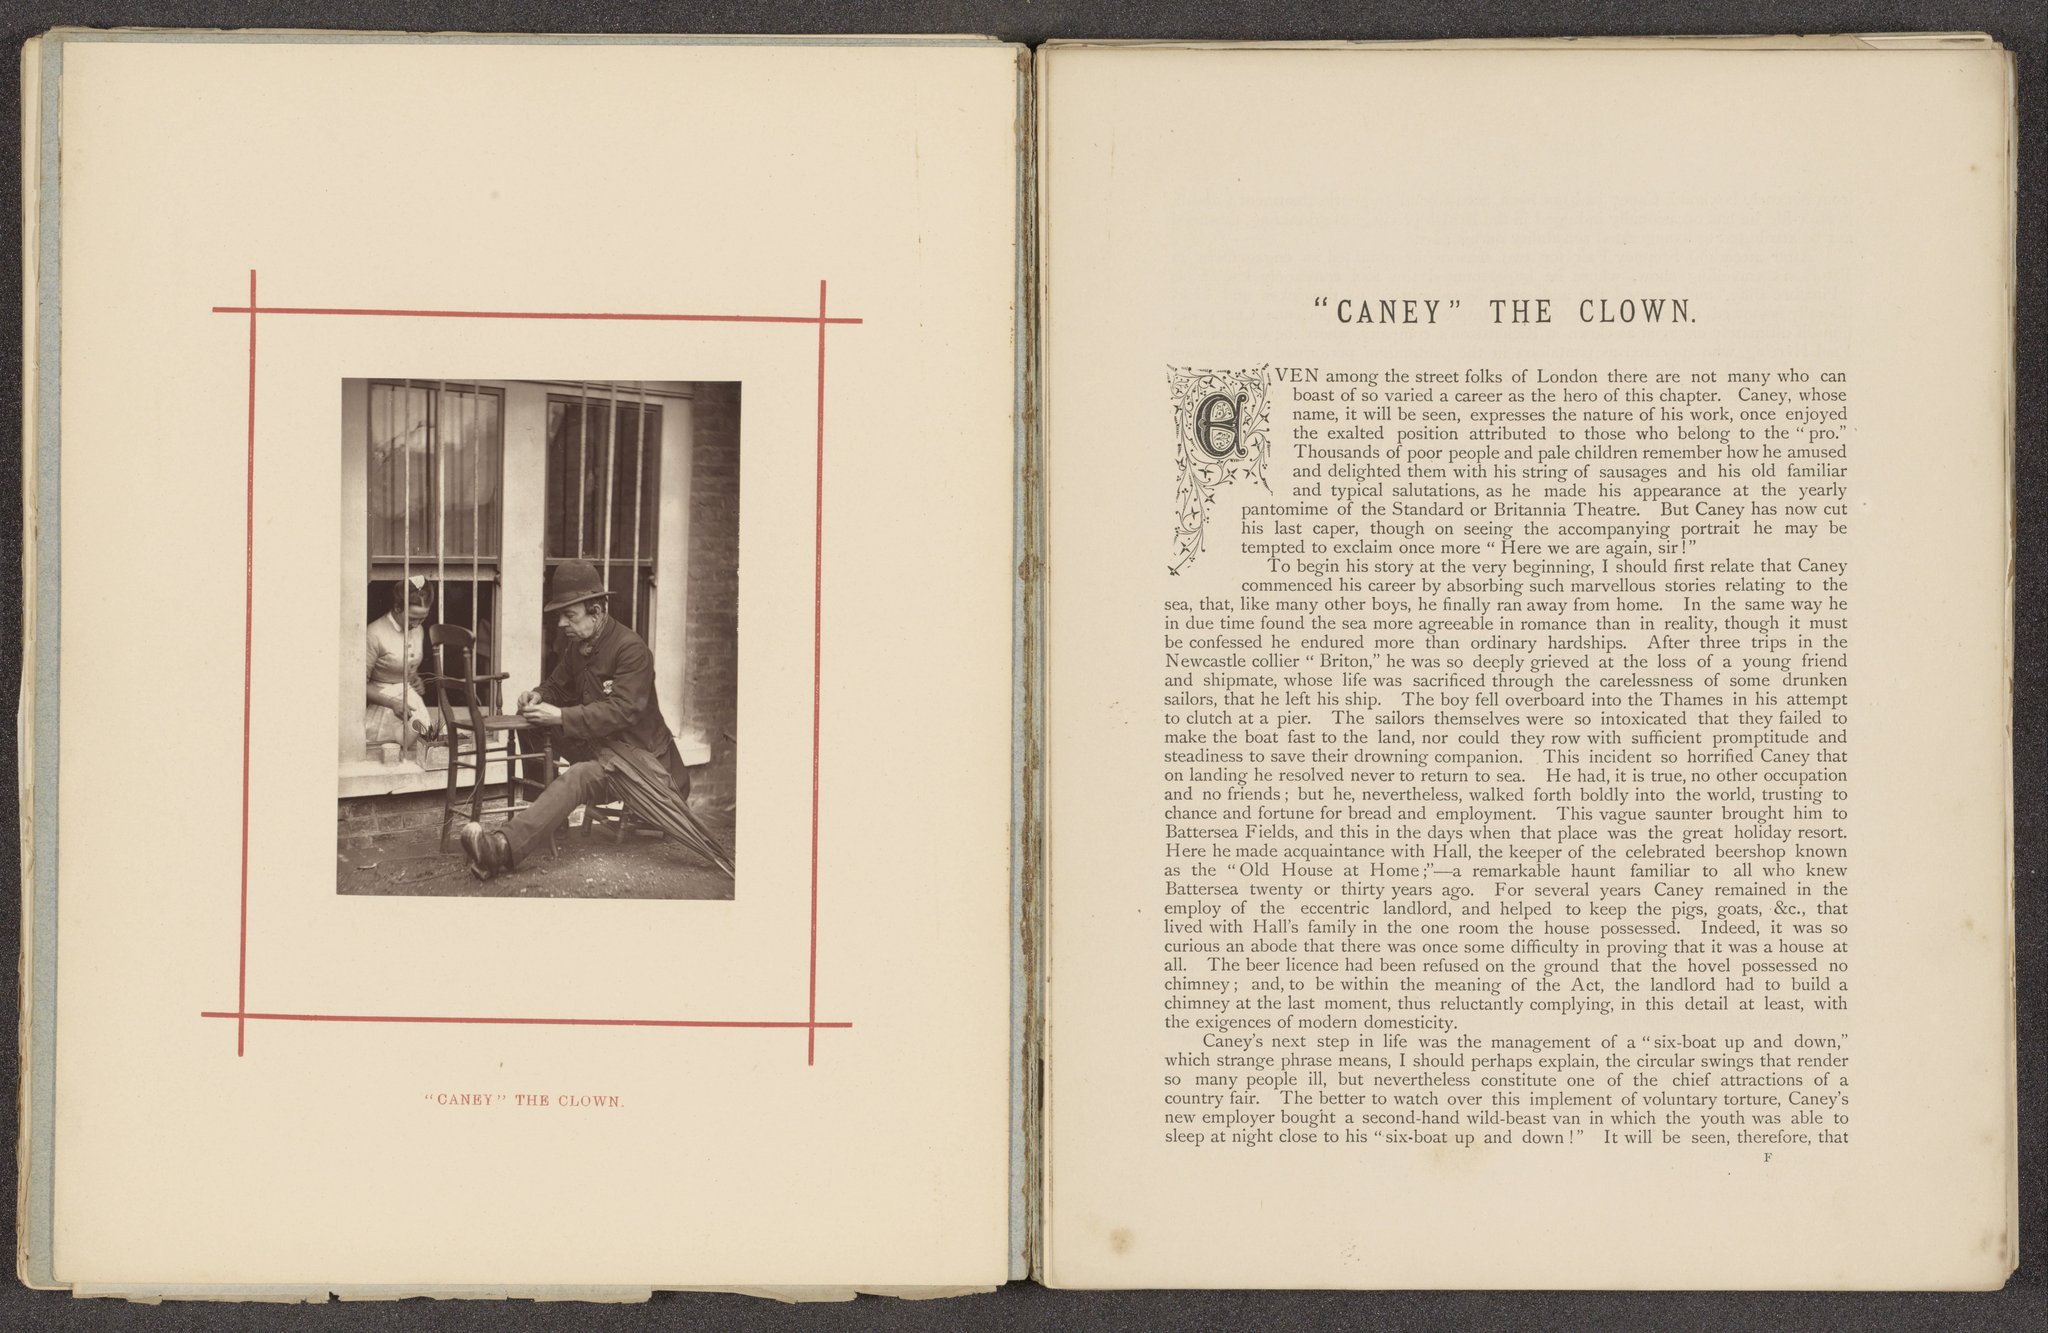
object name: page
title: "Caney" the clown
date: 1876-1877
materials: paper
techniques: woodburytype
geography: london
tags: joiner, cabinet maker, 'ébéniste', clown, london